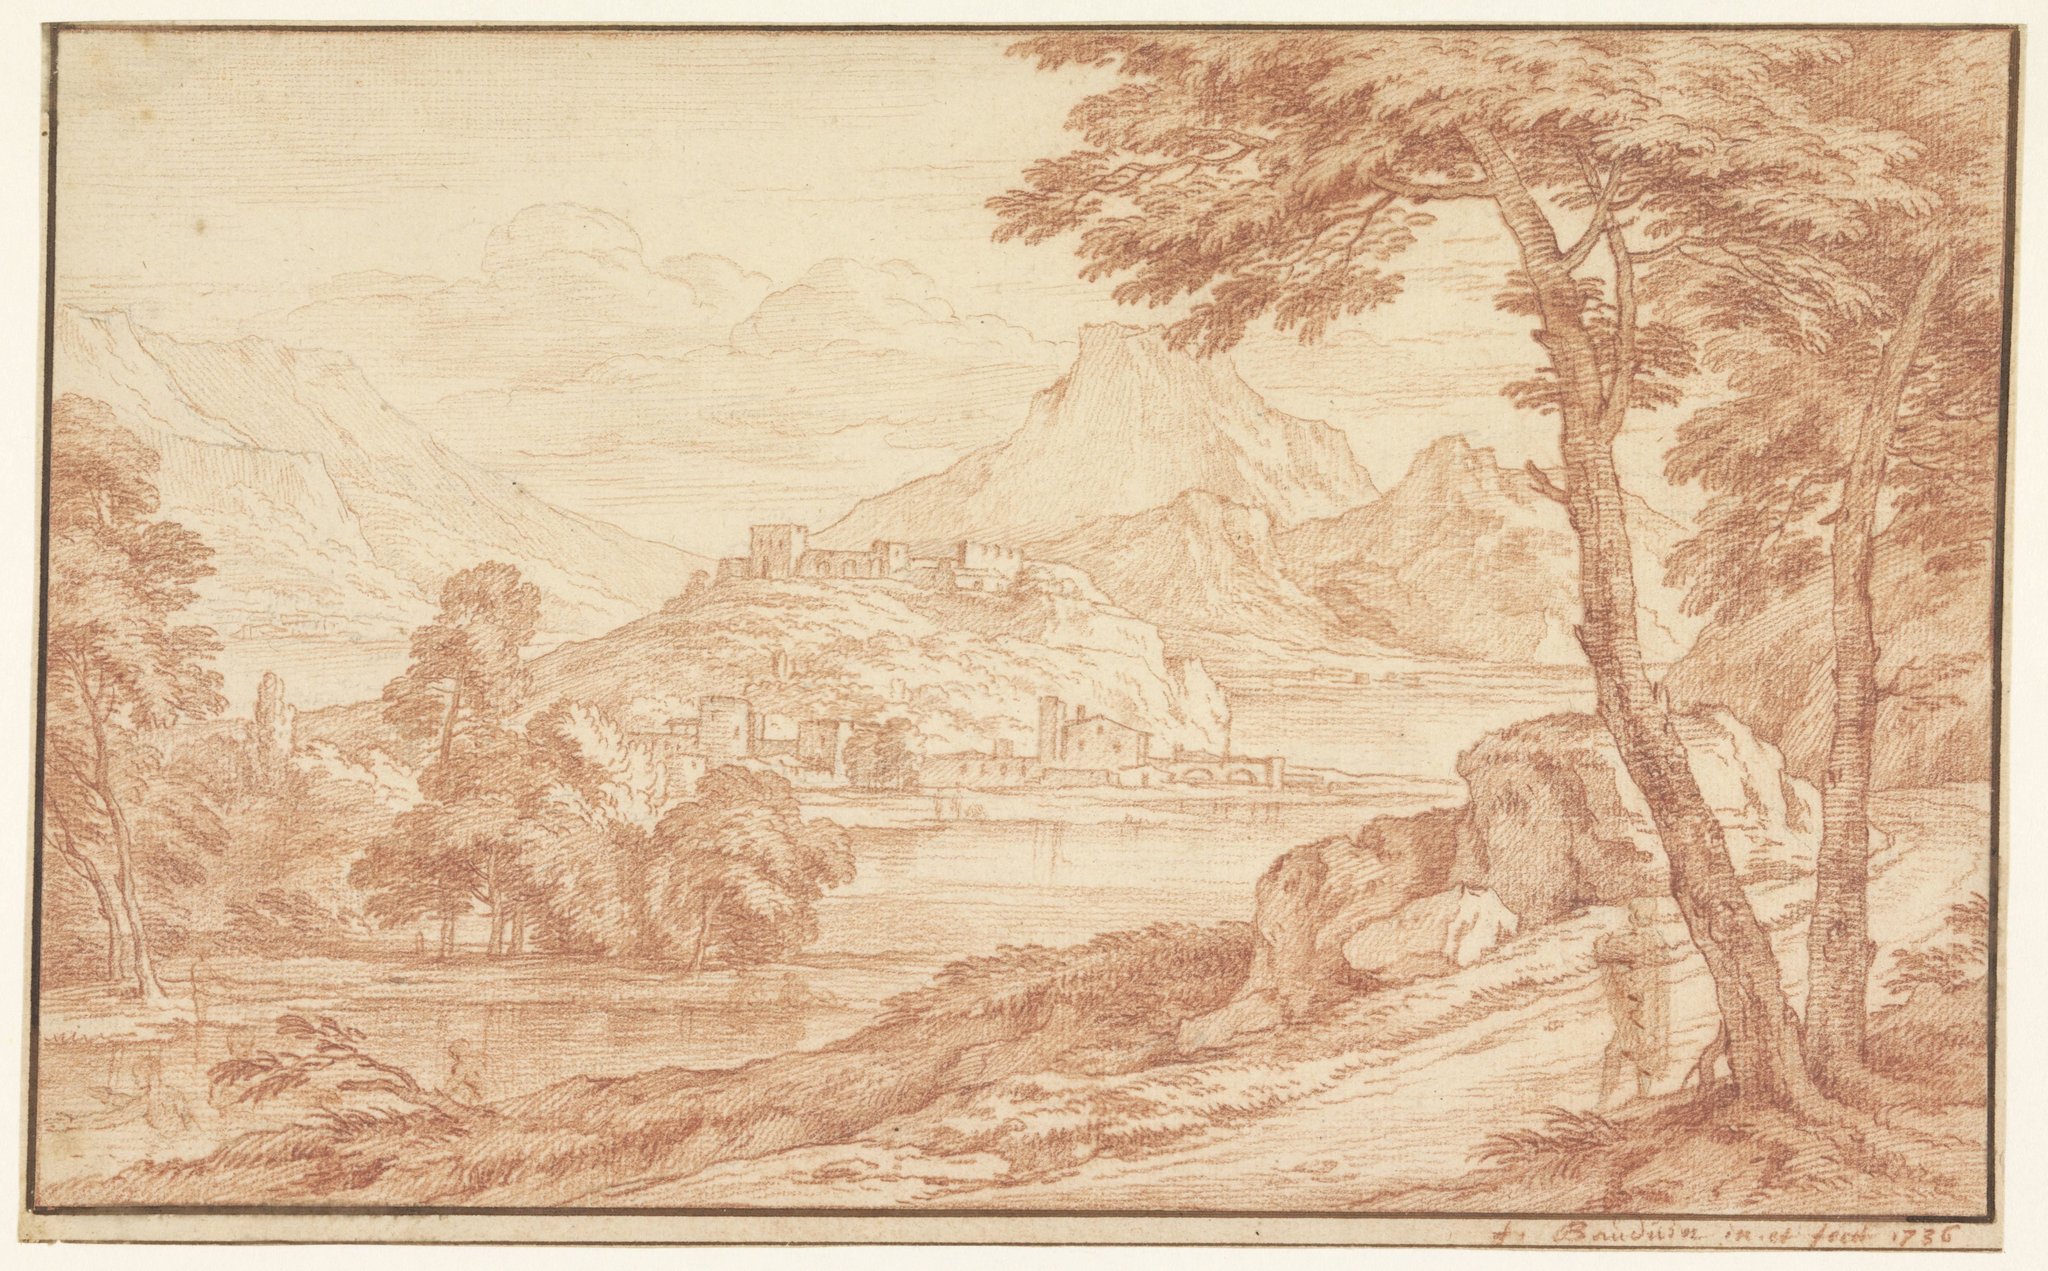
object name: drawing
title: Landschap met een dorp aan het water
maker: frans boudewijns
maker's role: draughtsman, painter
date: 1736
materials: chalk, paper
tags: mountains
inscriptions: date: ‘1736’